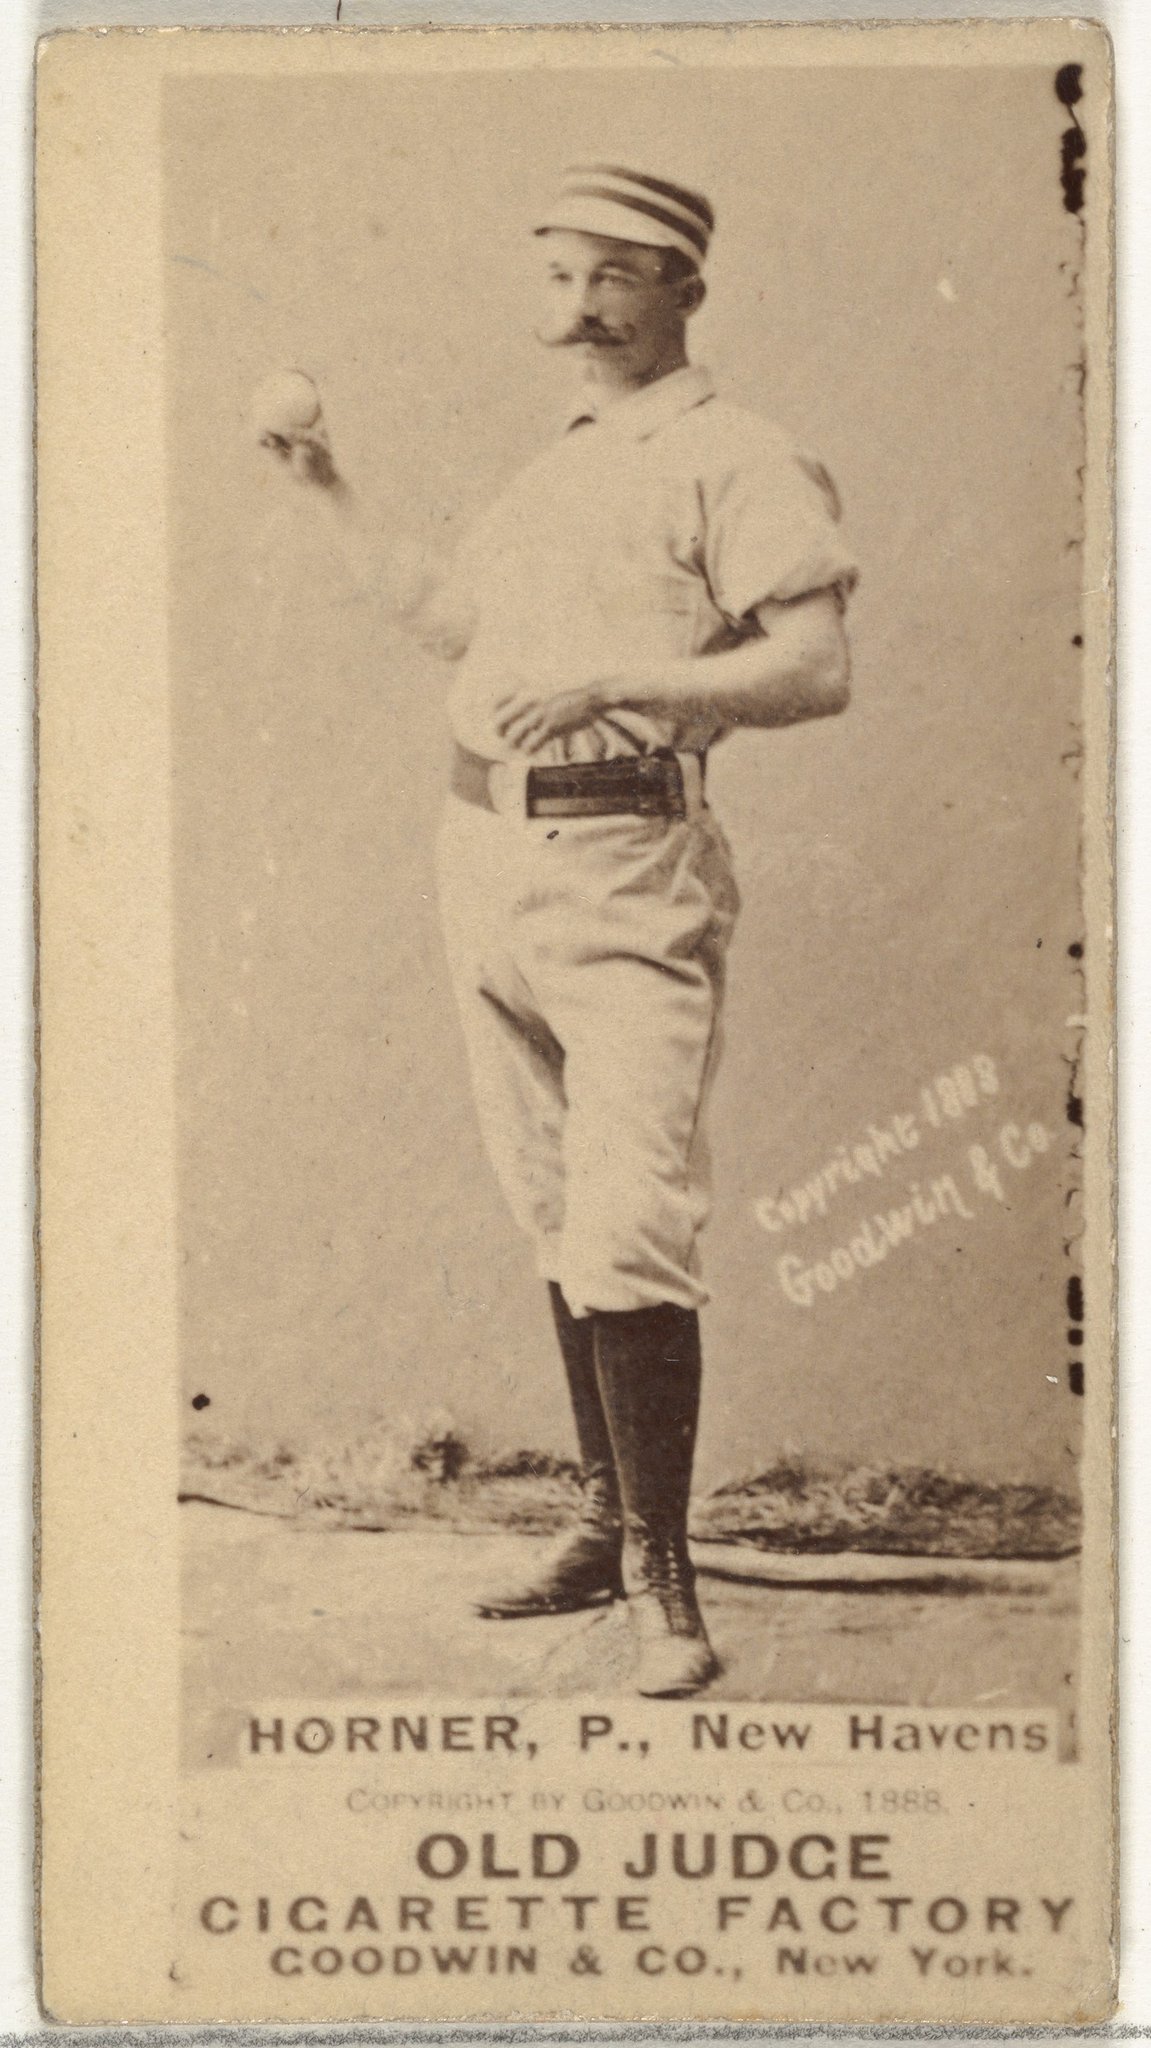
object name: baseball card, photograph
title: William "Jack" Frank Horner, Pitcher, New Haven, from the Old Judge series (N172) for Old Judge Cigarettes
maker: goodwin & company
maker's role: publisher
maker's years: 1850-1950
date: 1888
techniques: albumen silver print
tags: men,portraits,baseball,athletes